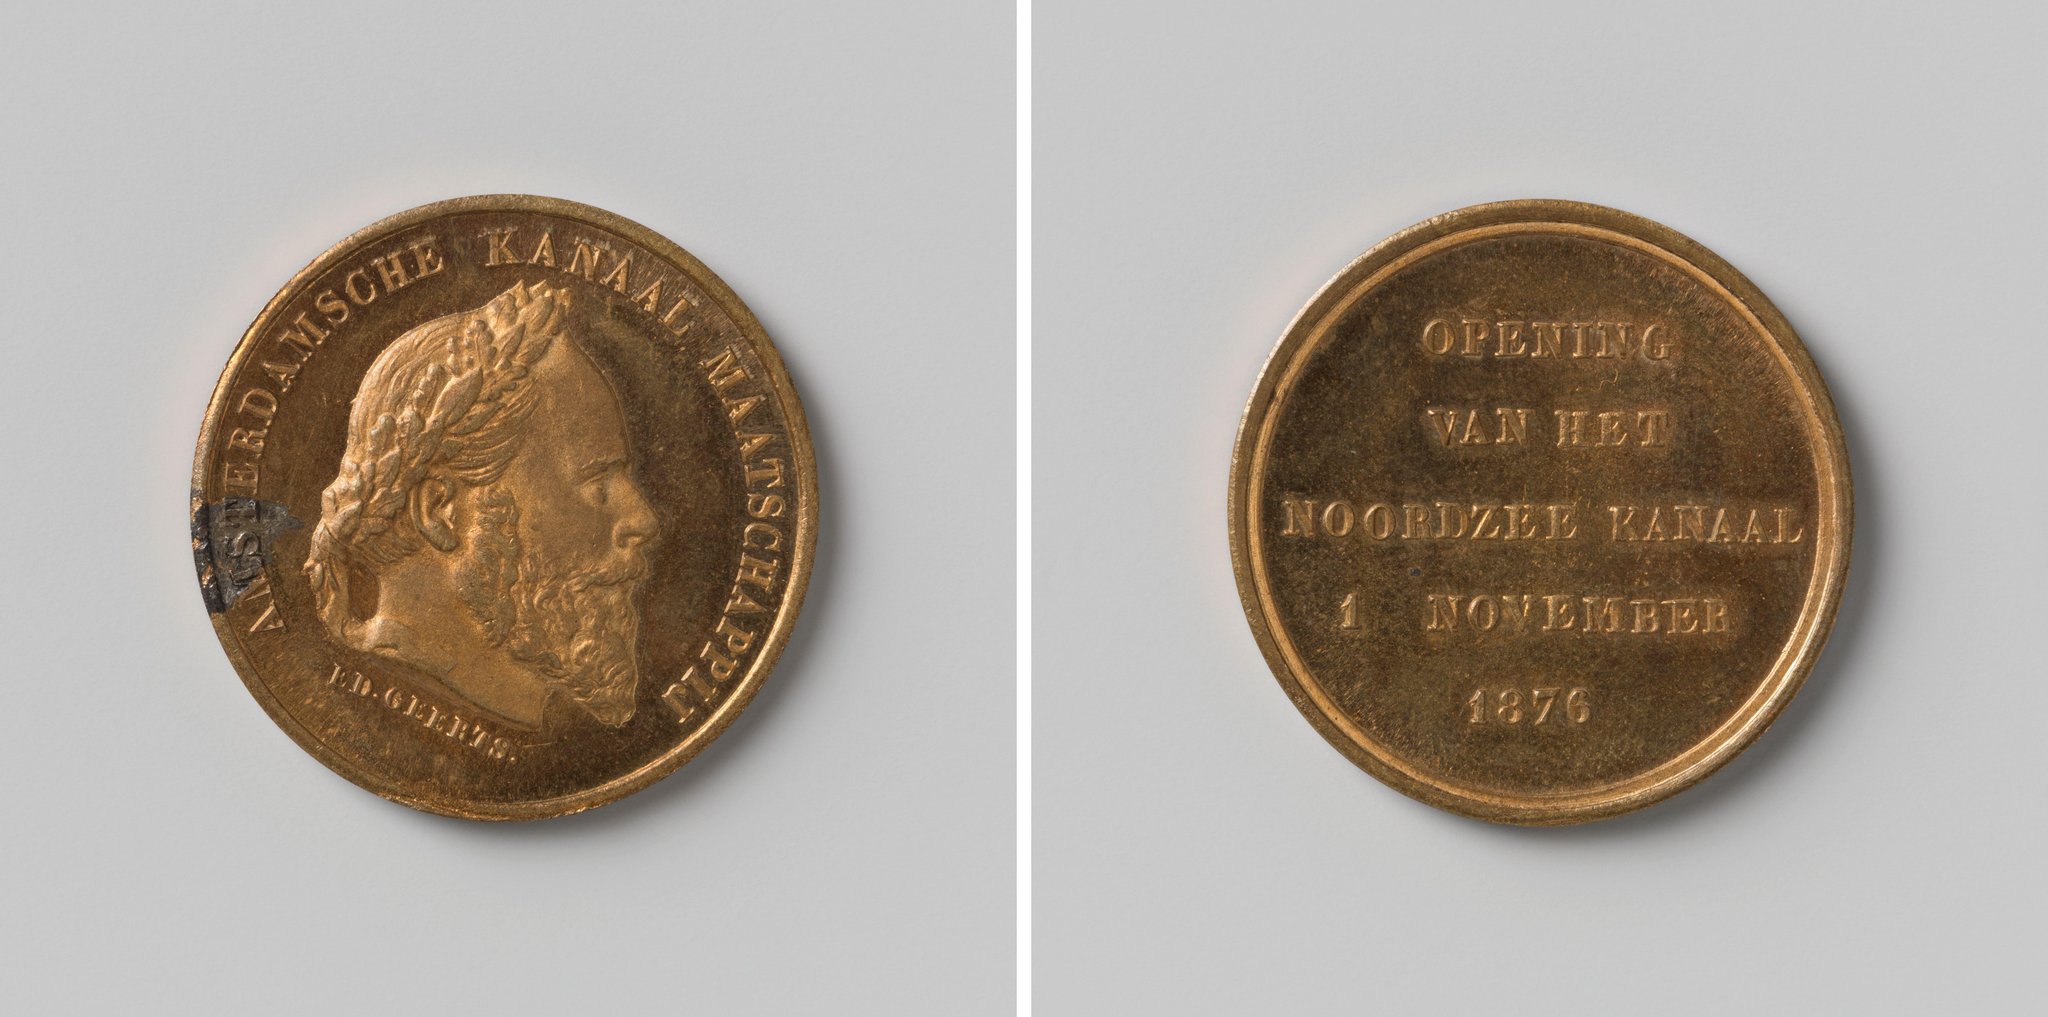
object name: history medal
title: Opening van het Noordzeekanaal, ter ere van Willem III, koning der Nederlanden, penning geslagen op last van de Amsterdamsche Kanaal Maatschappij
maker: edouard louis geerts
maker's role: medailleur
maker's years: 1846-1889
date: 1876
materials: bronze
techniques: gilding, striking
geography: brussels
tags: brussels, willem iii (koning der nederlanden)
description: Bronzen penning. Voorzijde: borststuk man met eikekrans binnen omschrift. Keerzijde: opschrift.